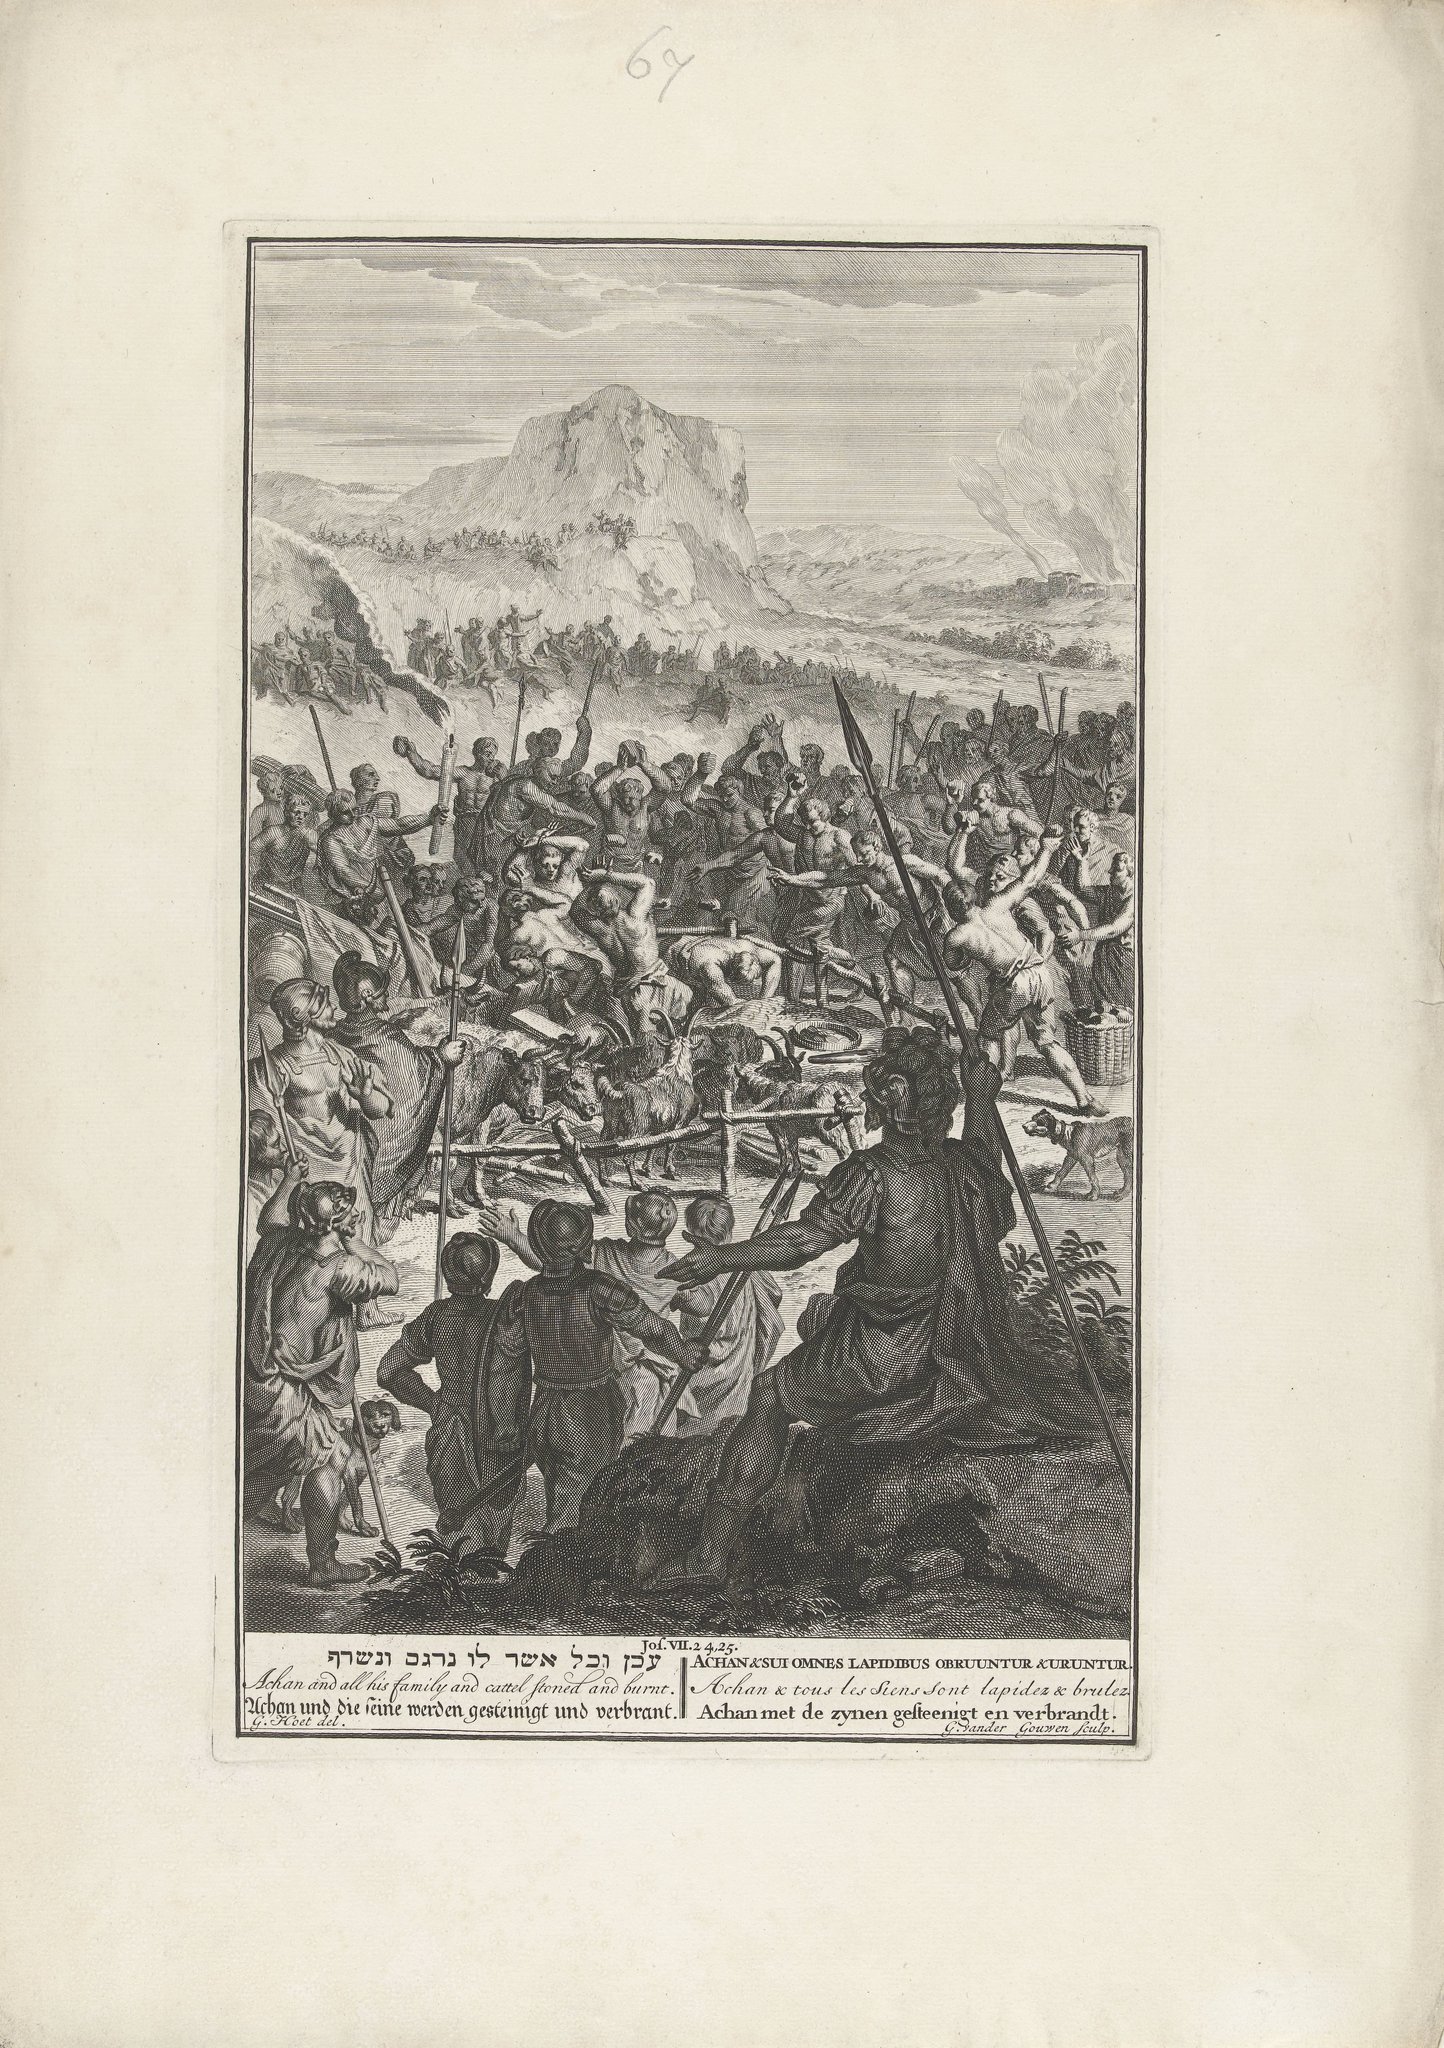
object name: print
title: Steniging van Achan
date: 1728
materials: paper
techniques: engraving, etching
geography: the hague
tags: achan and his family are stoned and burned (aftermath of the fall of jericho)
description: Achan wordt samen met zijn familie en zijn bezittingen gestenigd door de Israëlieten. Op de achtergrnd wordt de brandstapel klaargemaakt. (Joz. 7:2, 4, 25). De prent heeft een Hebreeuws, Latijns, Frans, Engels, Duits en Nederlands onderschrift.